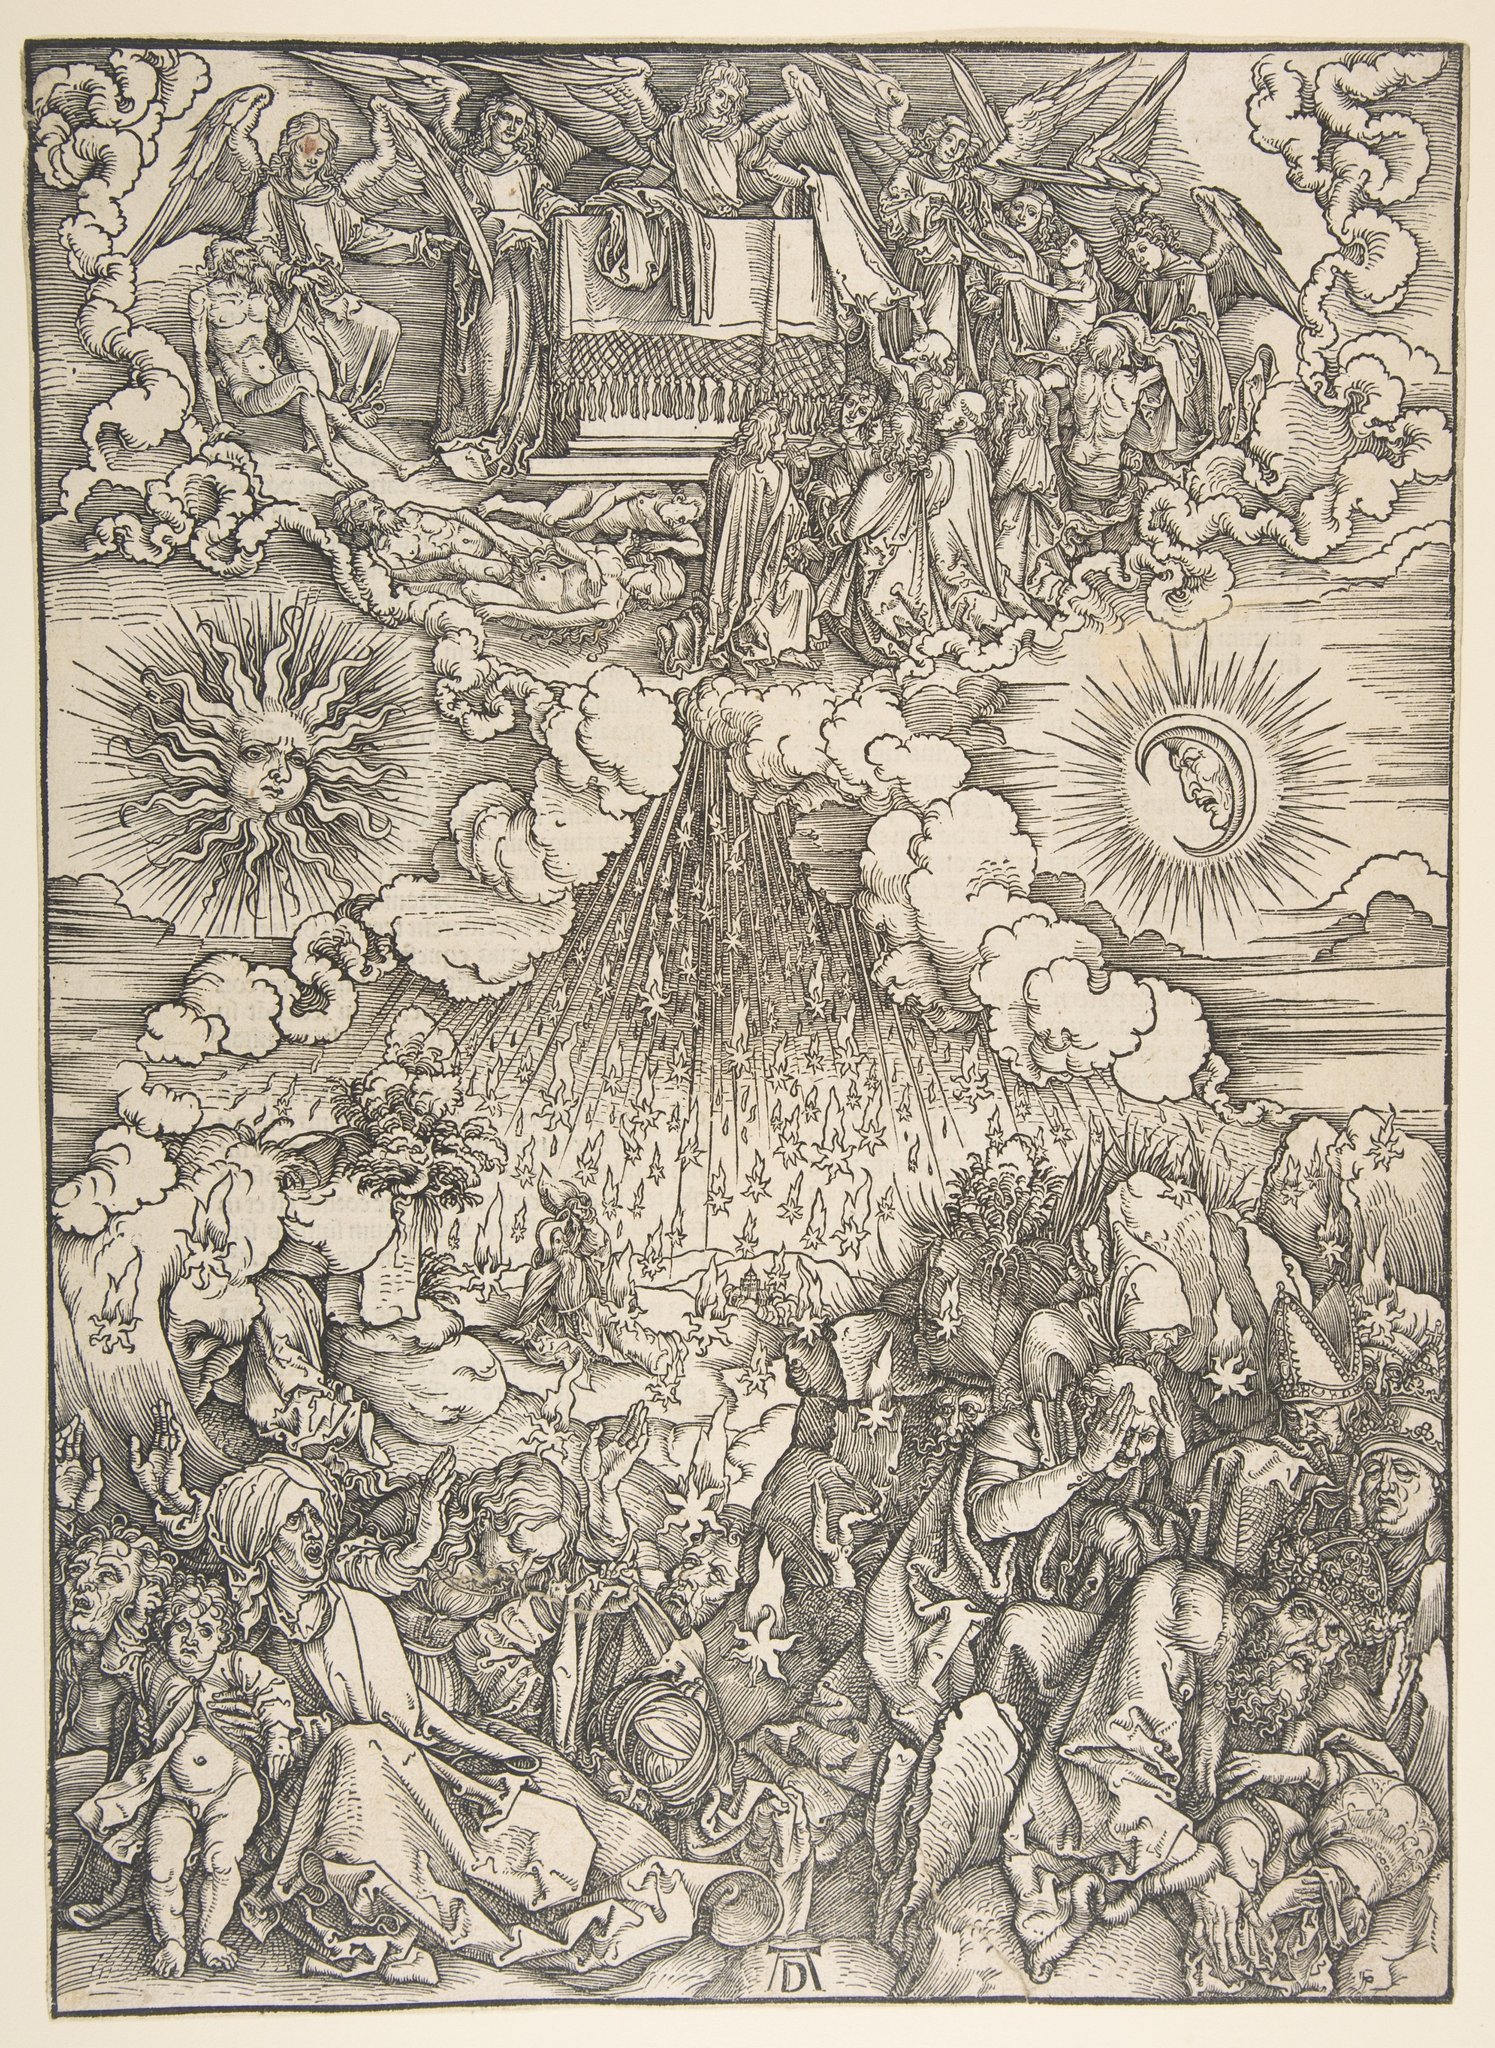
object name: print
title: The Opening of the Fifth and Sixth Seals, from "The Apocalypse"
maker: albrecht dürer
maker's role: artist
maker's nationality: german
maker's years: 1471-1528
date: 1497-1498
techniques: woodcut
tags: infants,men,women,angels,apocalypse